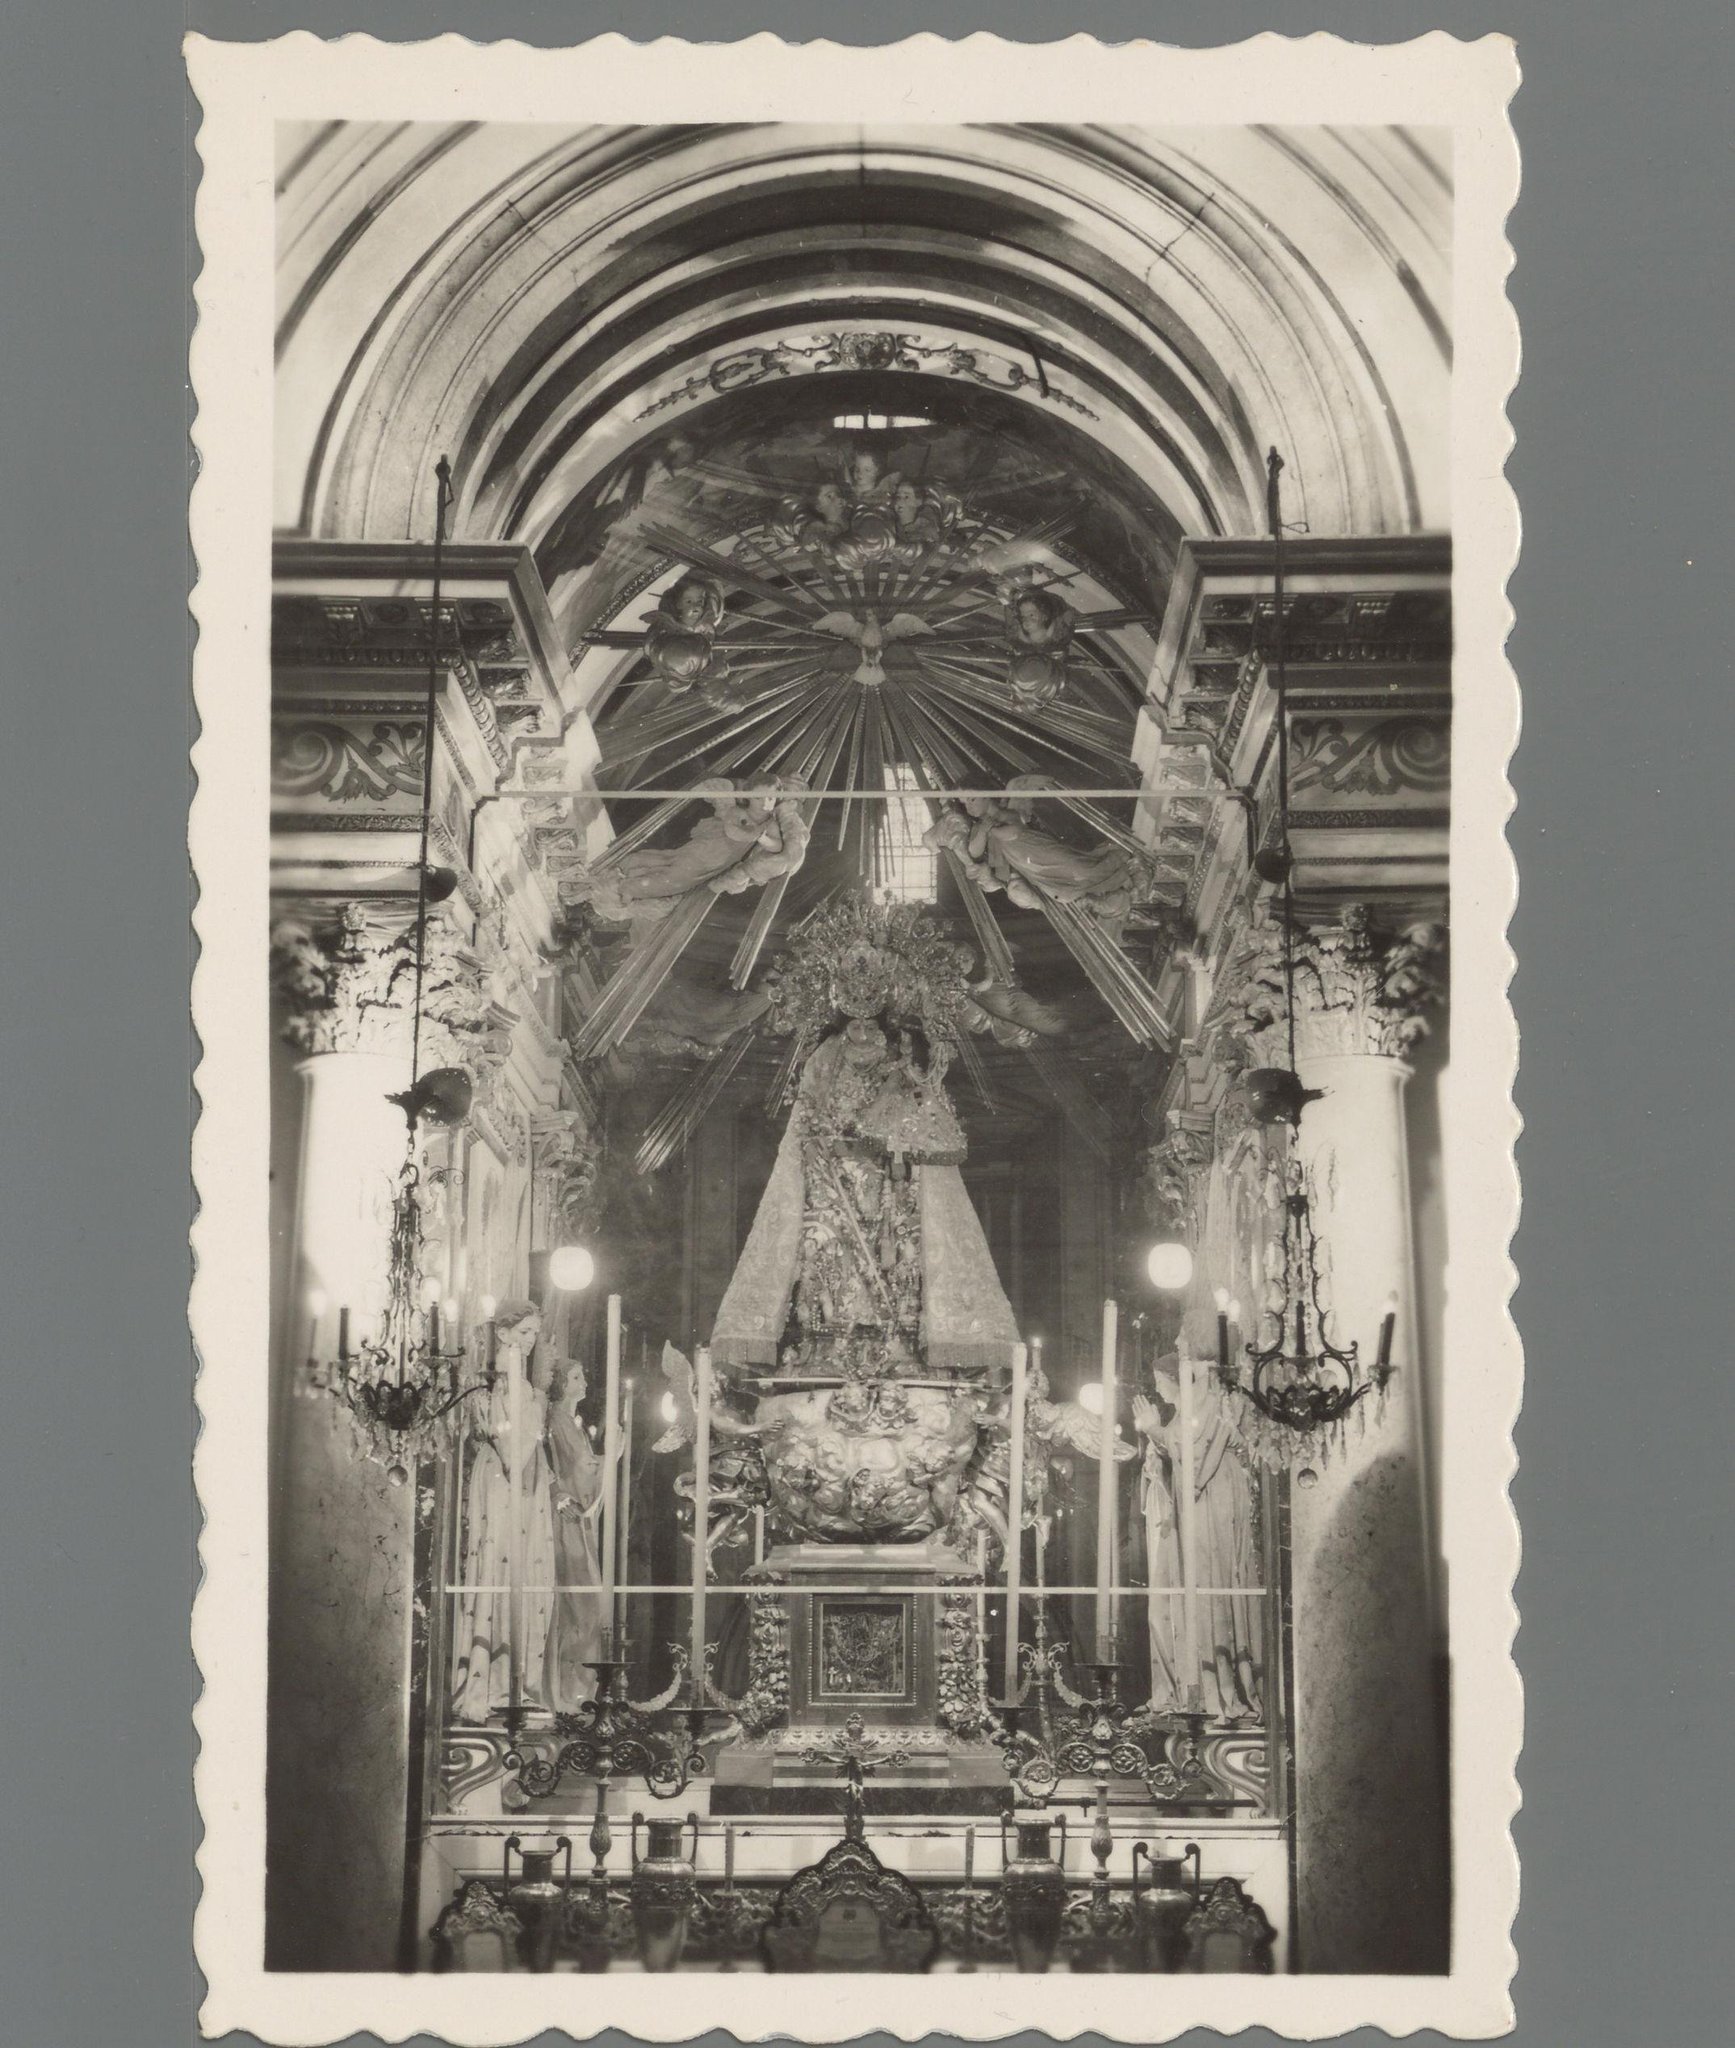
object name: photograph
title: Valencia. N.a S.a de los Desamparados. Patrona / Notre-Dame des Abandonnés de Valencia / Virgin Mary of the Friendless. Patroness of Valencia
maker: Anonymous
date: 1930-1950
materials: paper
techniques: gelatin silver print, writing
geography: valencia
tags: interior of church